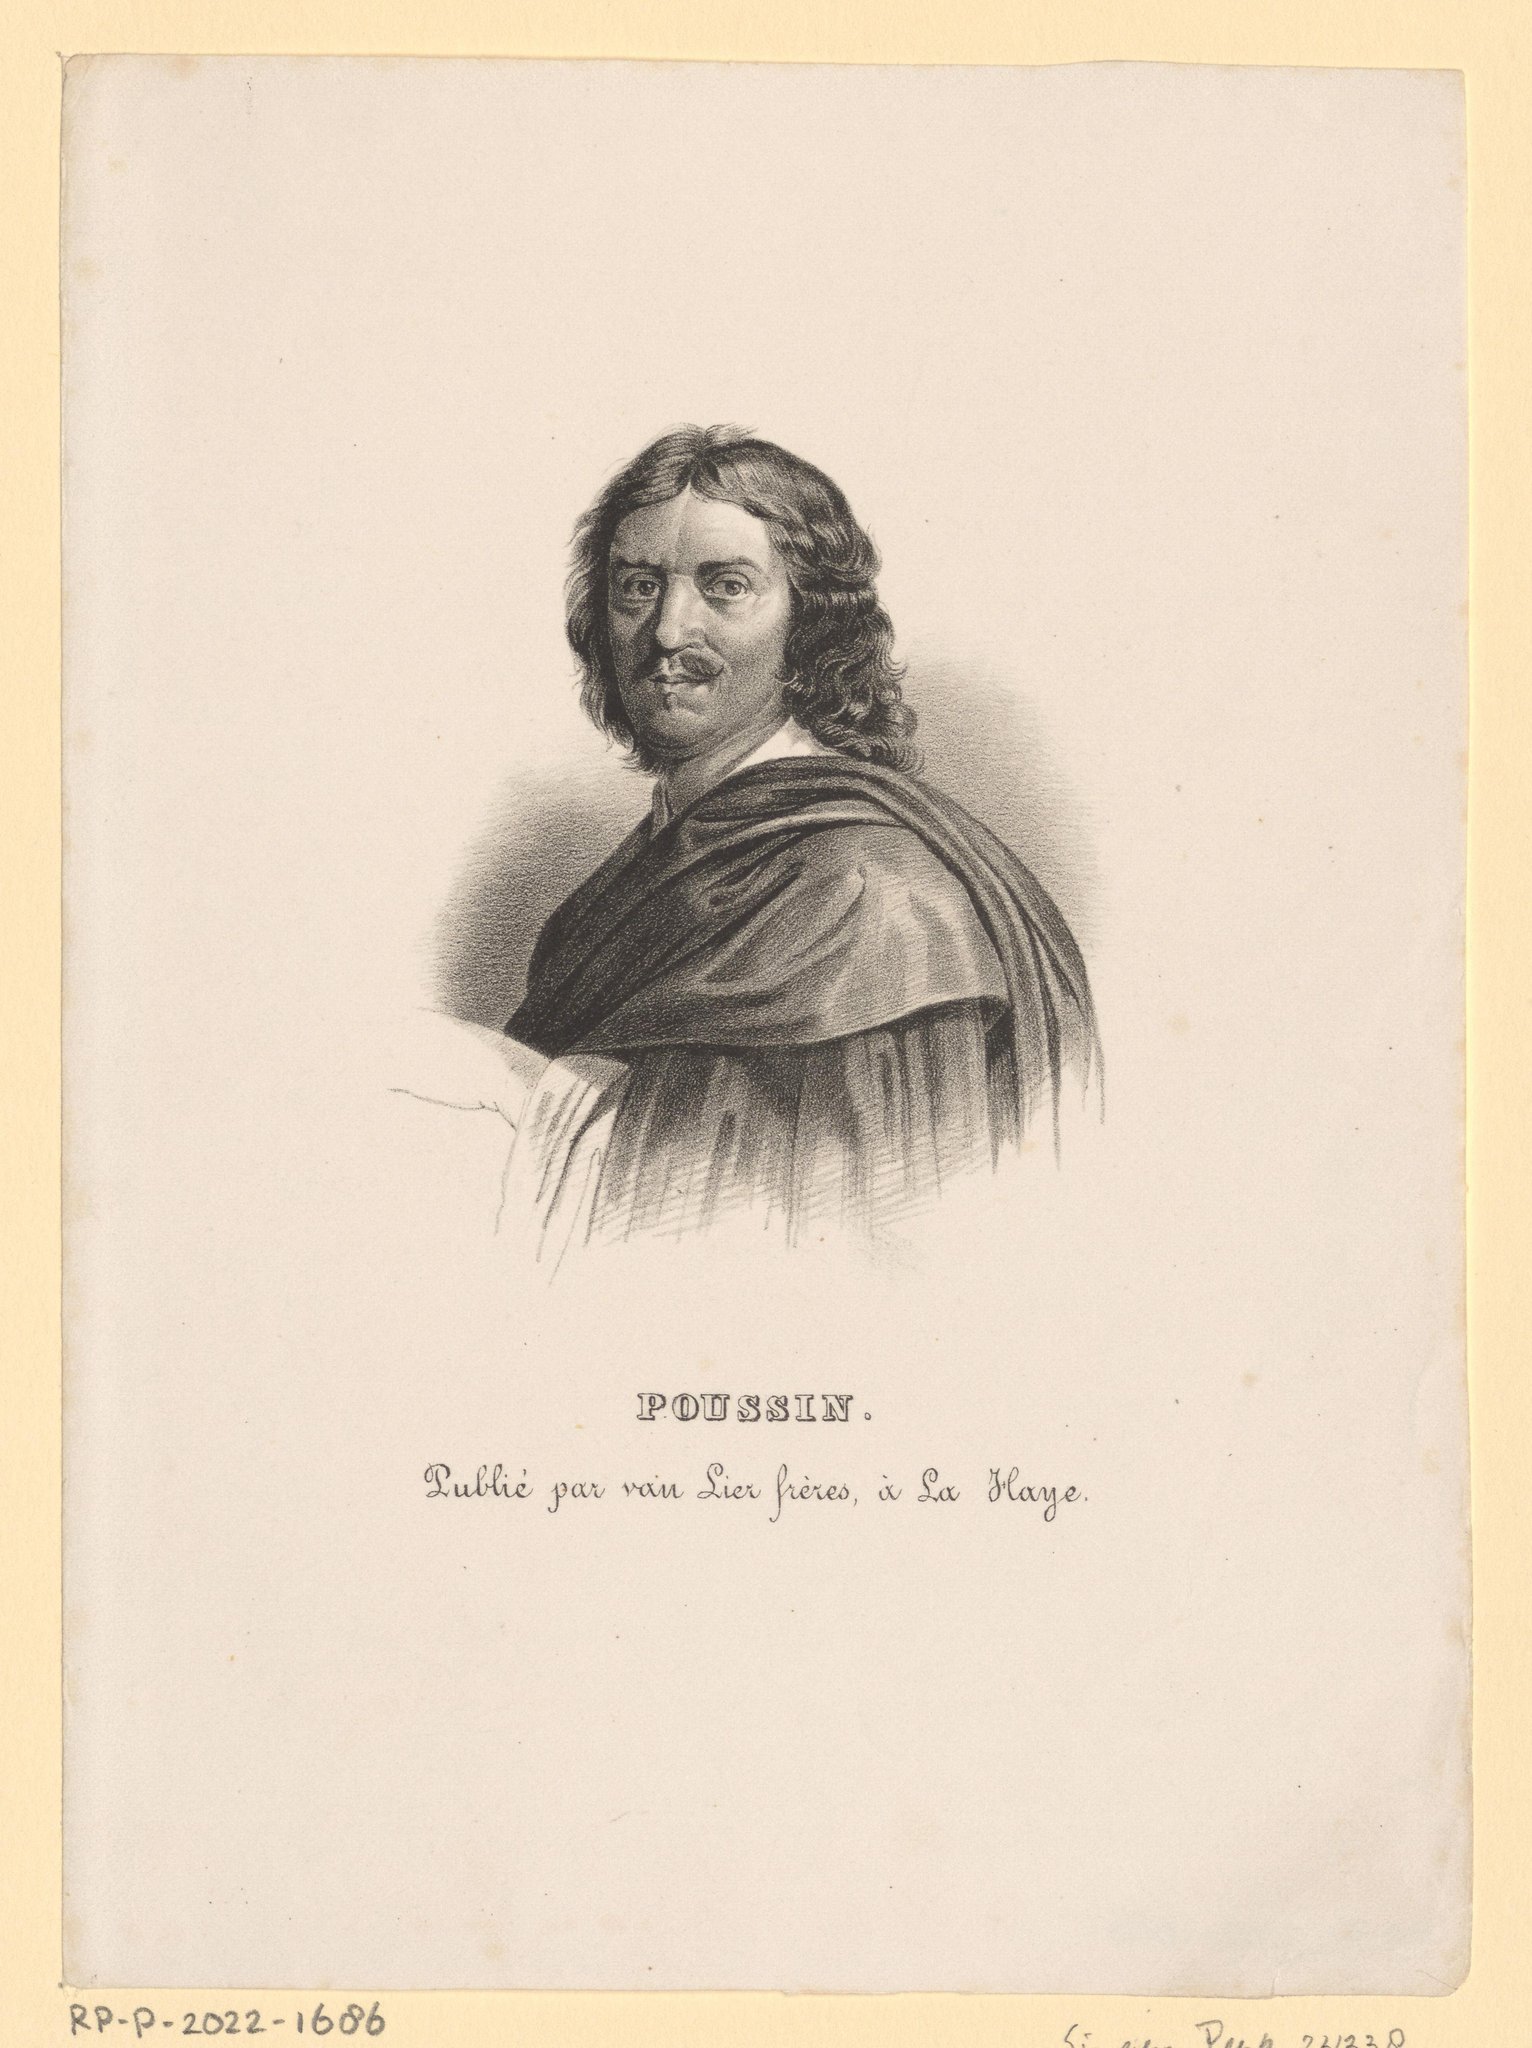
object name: print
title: Portret van Nicolas Poussin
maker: Anonymous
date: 1833-1846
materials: paper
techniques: lithograph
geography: the hague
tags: rome, painter, draughtsman, nicolas poussin, historical persons, portrait, self-portrait of painter